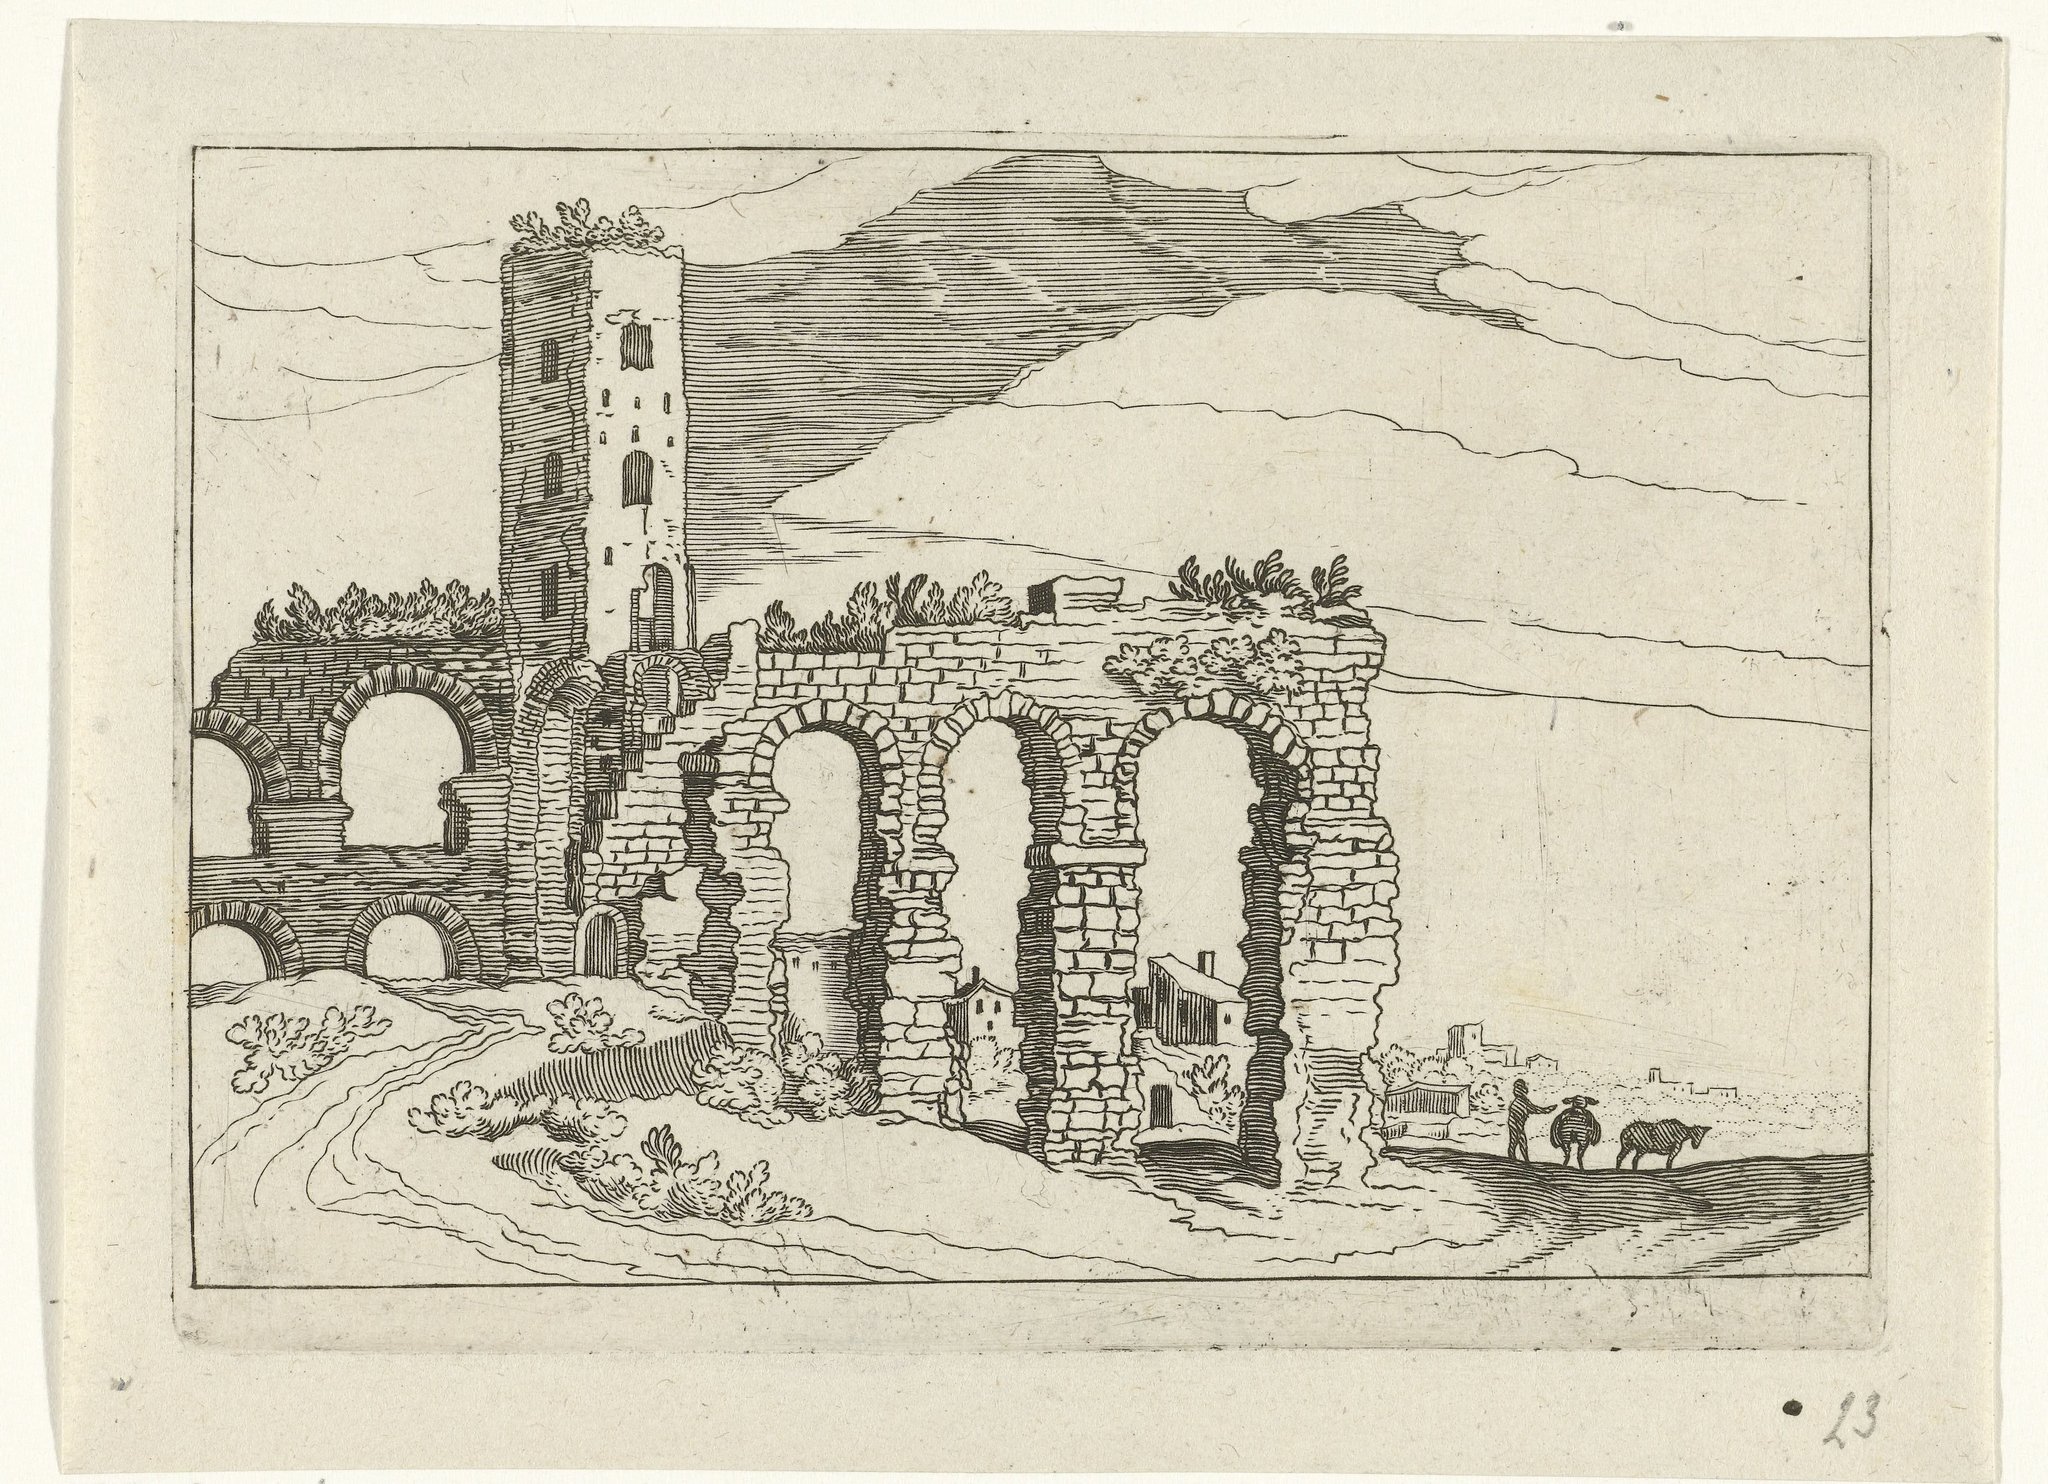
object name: print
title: Ruïne van aquaduct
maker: Anonymous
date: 1594-1685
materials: paper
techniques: engraving, etching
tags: landscape with ruins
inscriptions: collector's mark: Lugt 2228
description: In een landschap ligt links de begroeide ruïne van een aquaduct met een toren. Rechts een weg met een figuur en twee ezels. Op de achtergrond een stad. Prent uit een serie Romeinse ruïnes, bestaande uit kopieën naar een prentserie van Willem van Nieulandt.